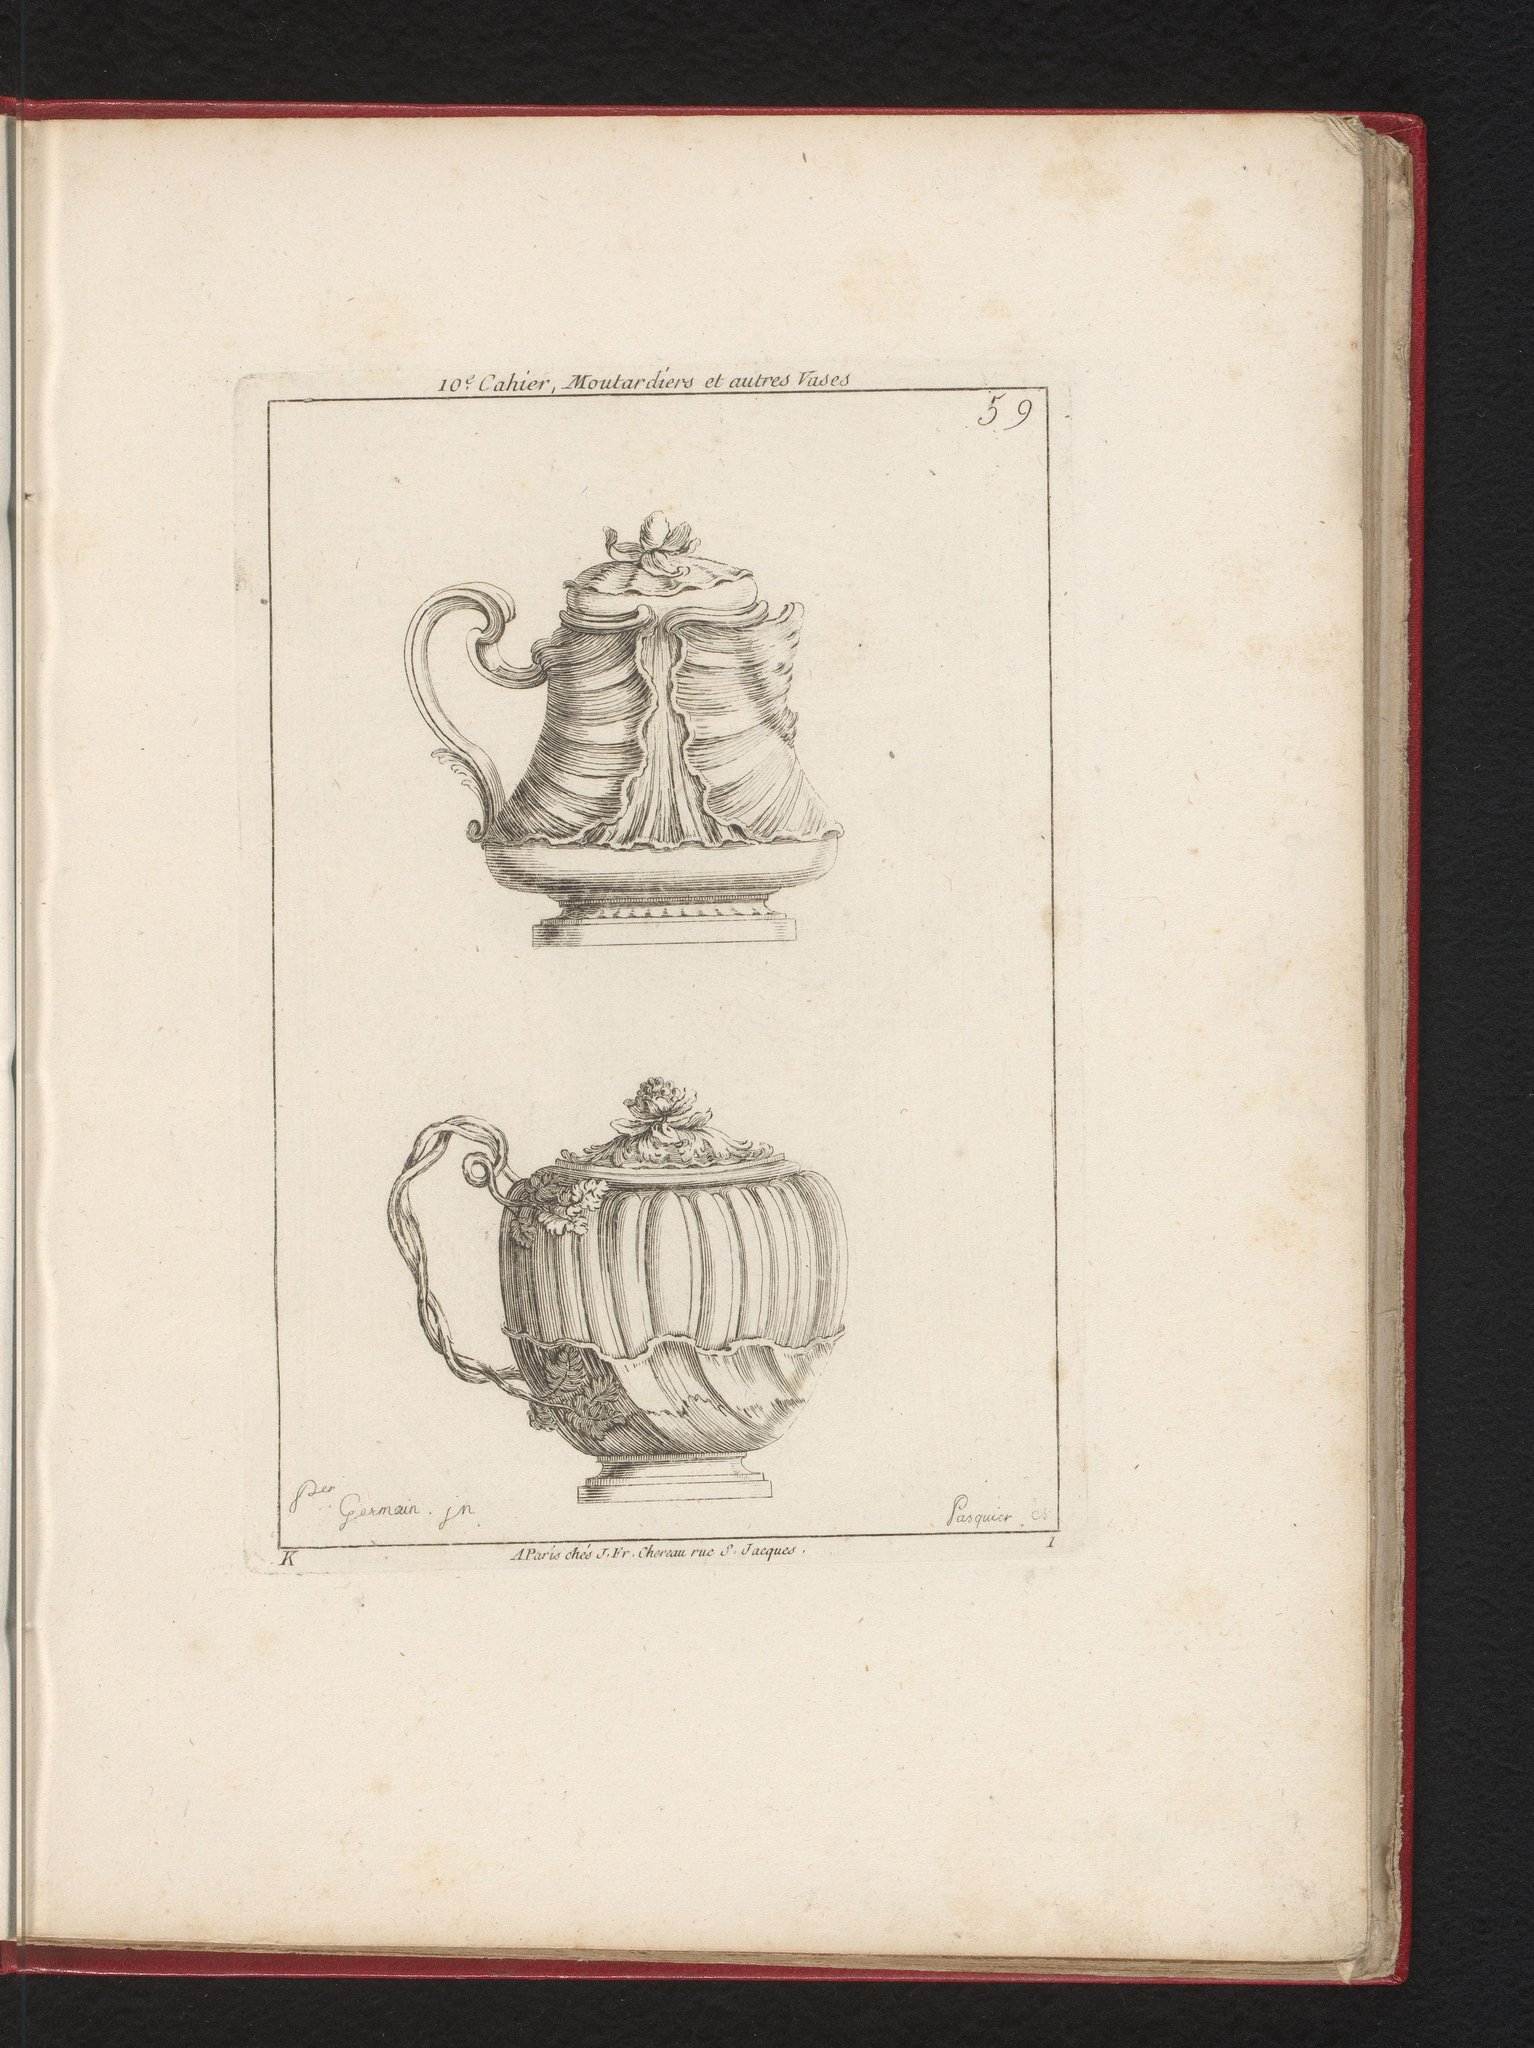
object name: album leaf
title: Twee ontwerpen voor mosterdpotten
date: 1748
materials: paper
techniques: etching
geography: paris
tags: mustard (+ foodstuffs in other container, e.g.: barrel, can, cask, tin, etc.)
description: Een aantal van de objecten in deze reeks heeft een eigen ondertitel, die verwijst naar genummerde 'cahiers' (afleveringen) waarin de prenten werden uitgegeven. Het is onduidelijk welke objecten recies bij welke aflevering horen. Daarom is die ondertitel enkel verwerkt bij de prent waarop die voorkomt.